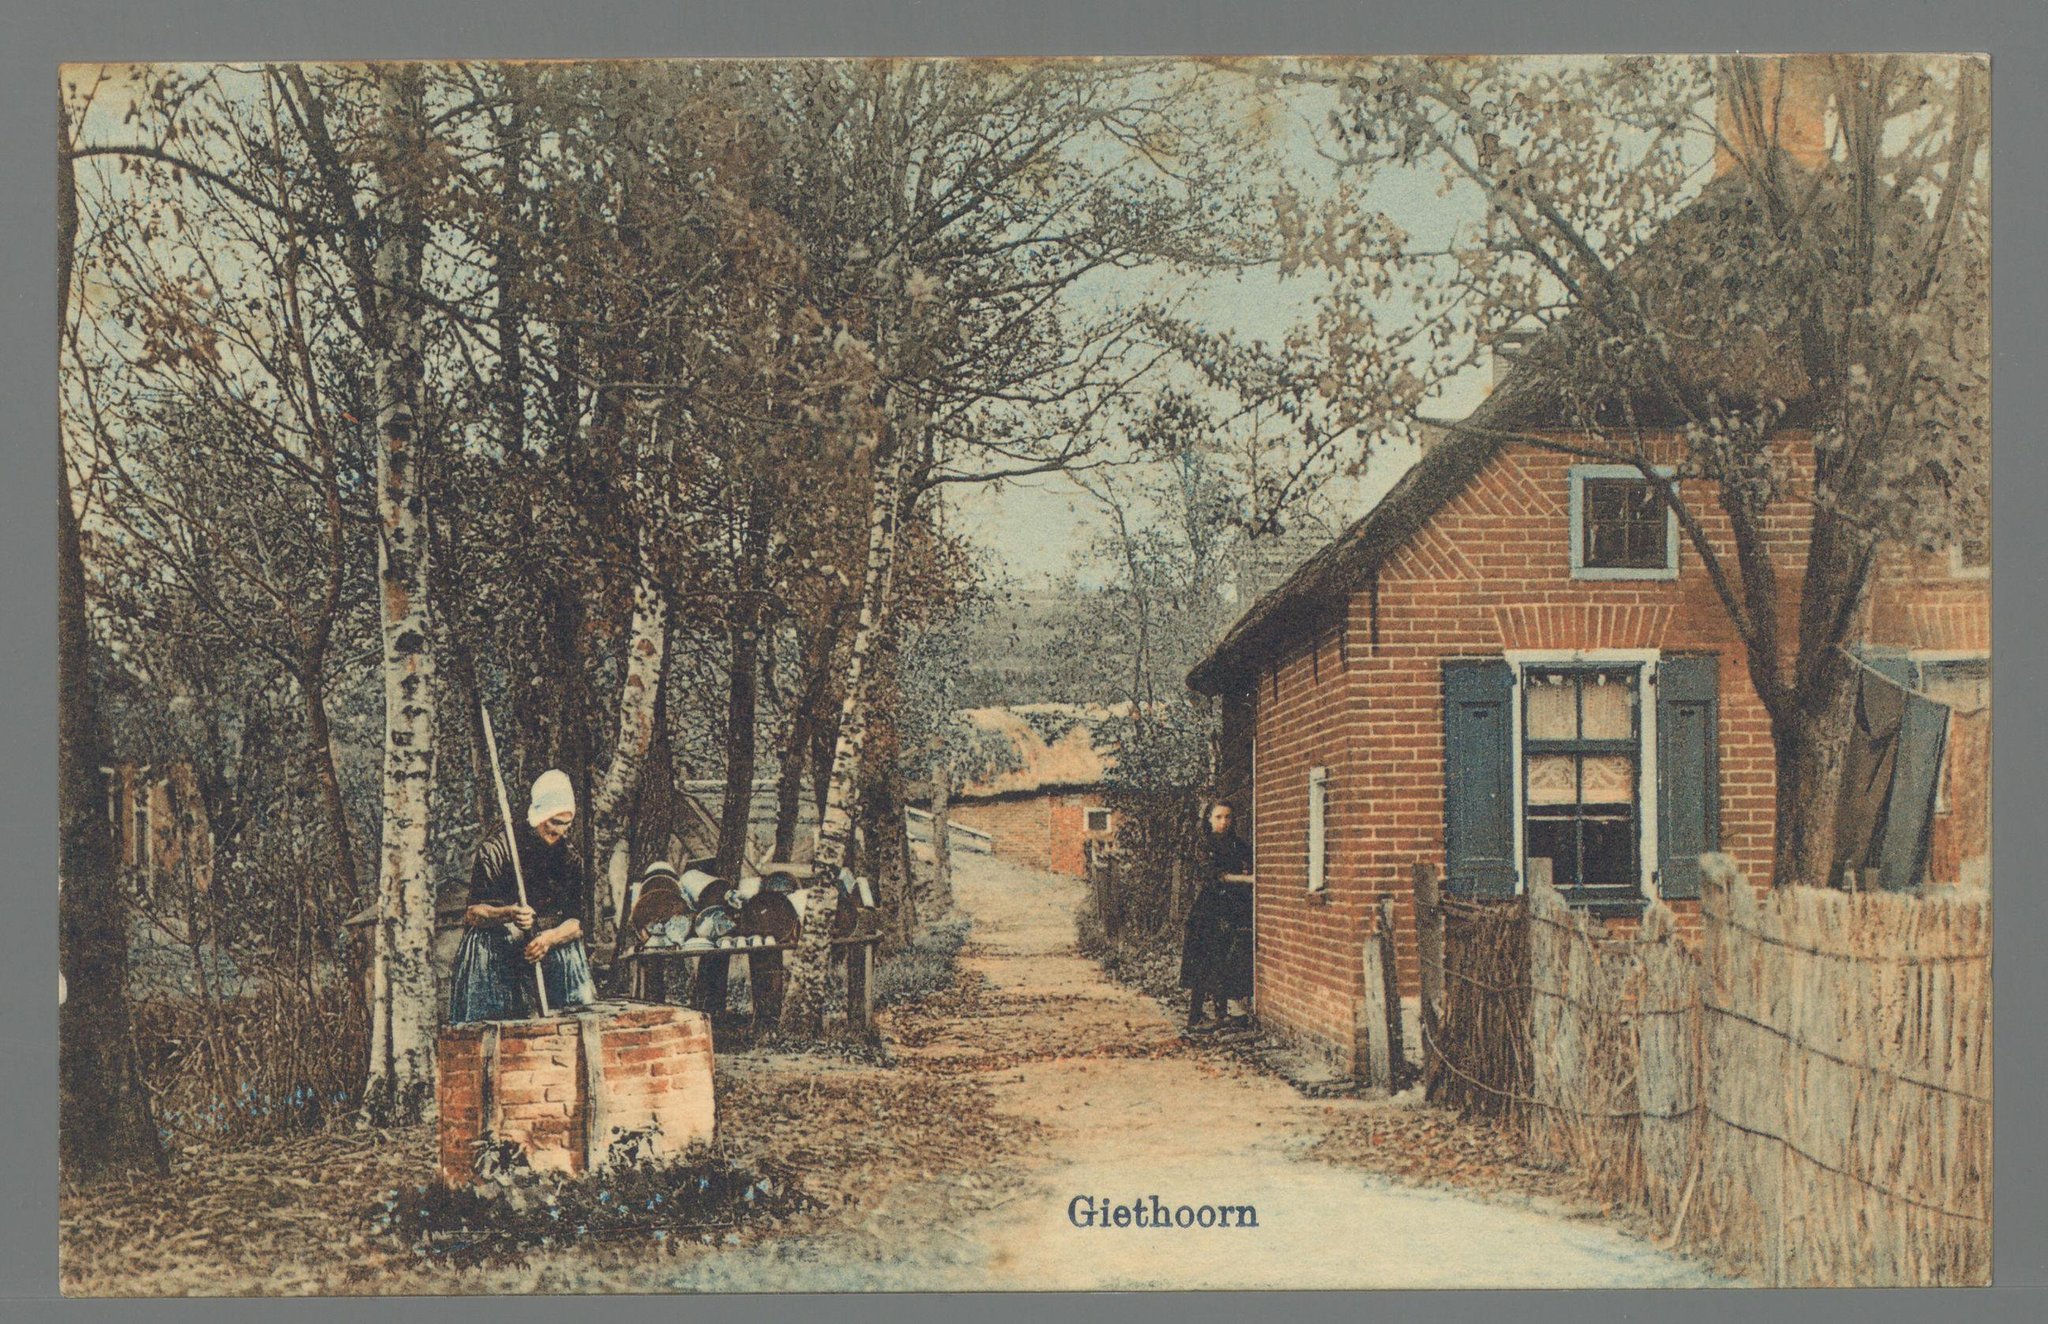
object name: photomechanical print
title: Giethoorn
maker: Anonymous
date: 1905-1916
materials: cardboard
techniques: collotype process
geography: berlin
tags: street